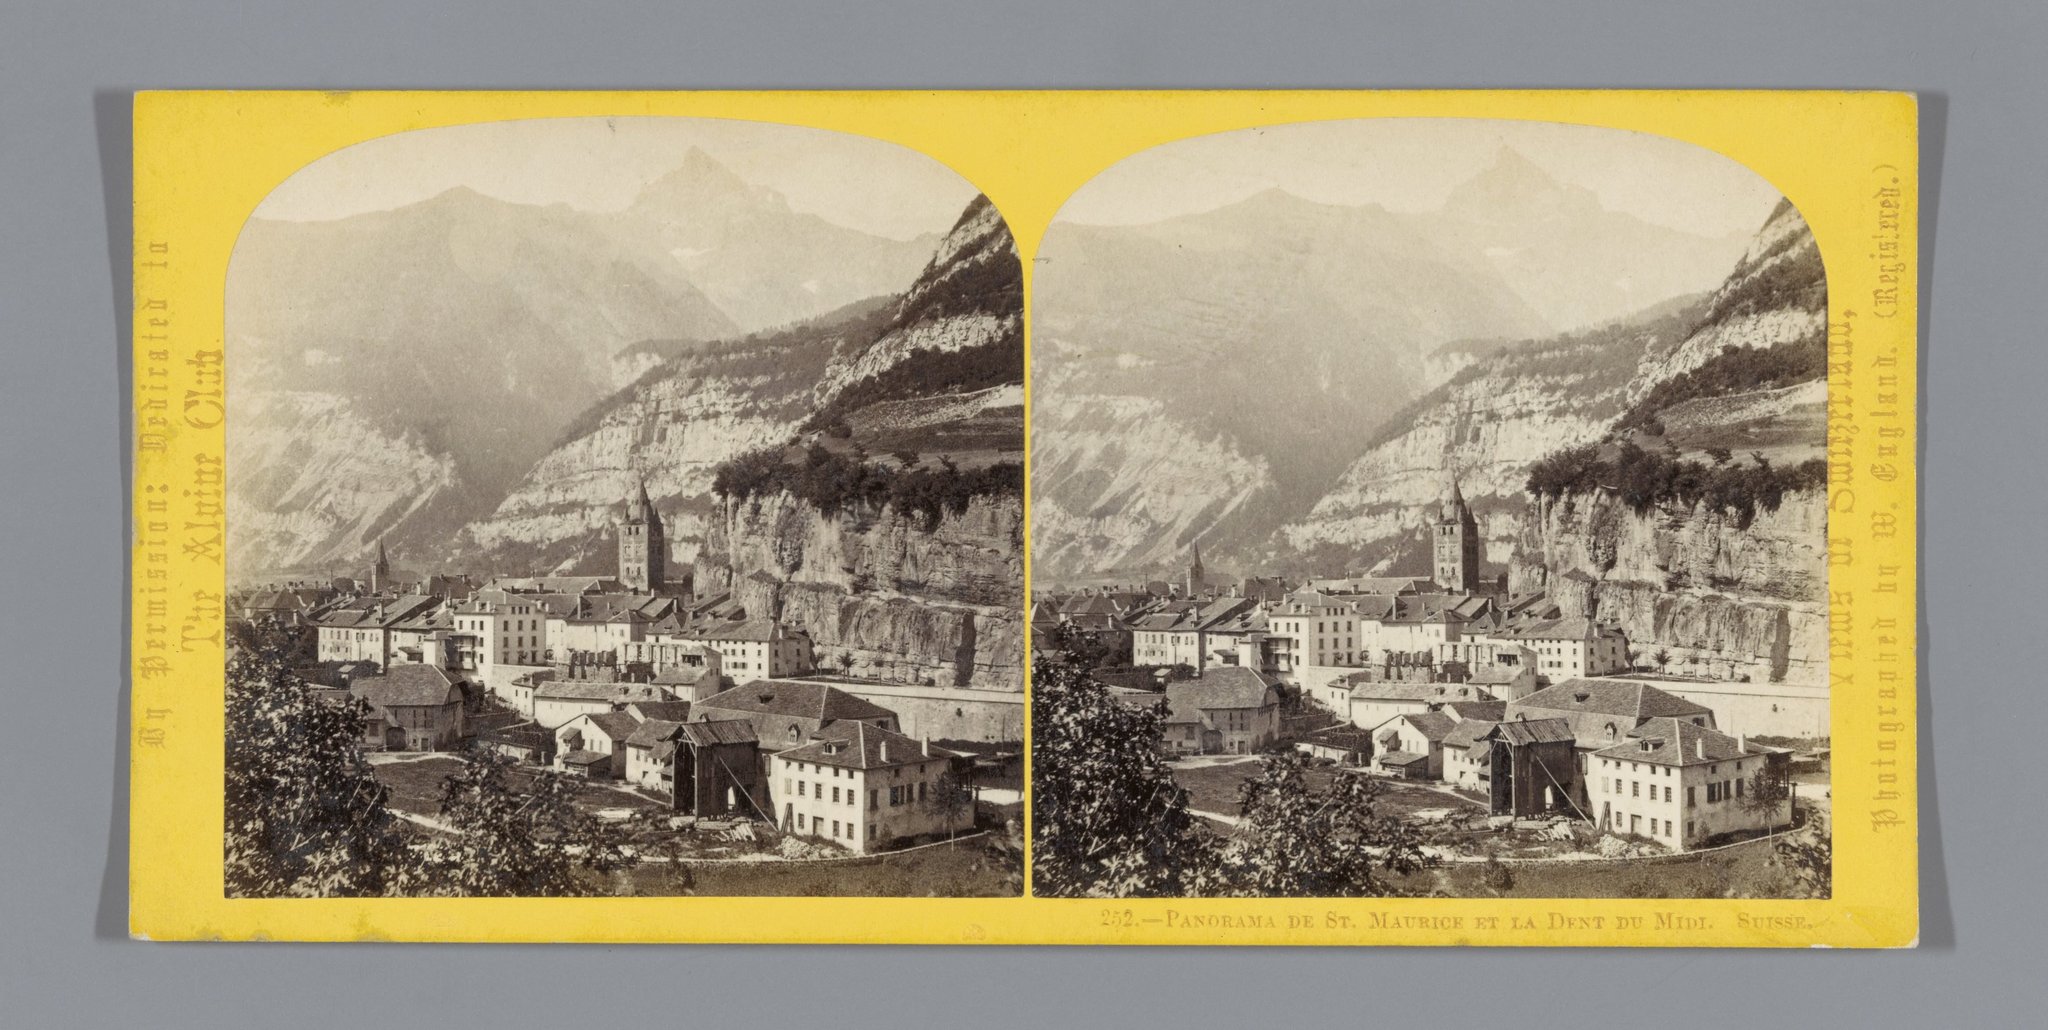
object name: stereograph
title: Panorama de St. Maurice et la Dent du Midi. Suisse.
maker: william england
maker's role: fotograaf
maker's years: 1816-1896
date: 1850-1880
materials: cardboard, photographic support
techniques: albumen print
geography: wallis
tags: city-view in general; 'veduta'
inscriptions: inscription: ‘Views of Switzerland, photographed by W. England. (Registered) Under the Special Patronage of the Alpine Club.’, number: ‘252.’